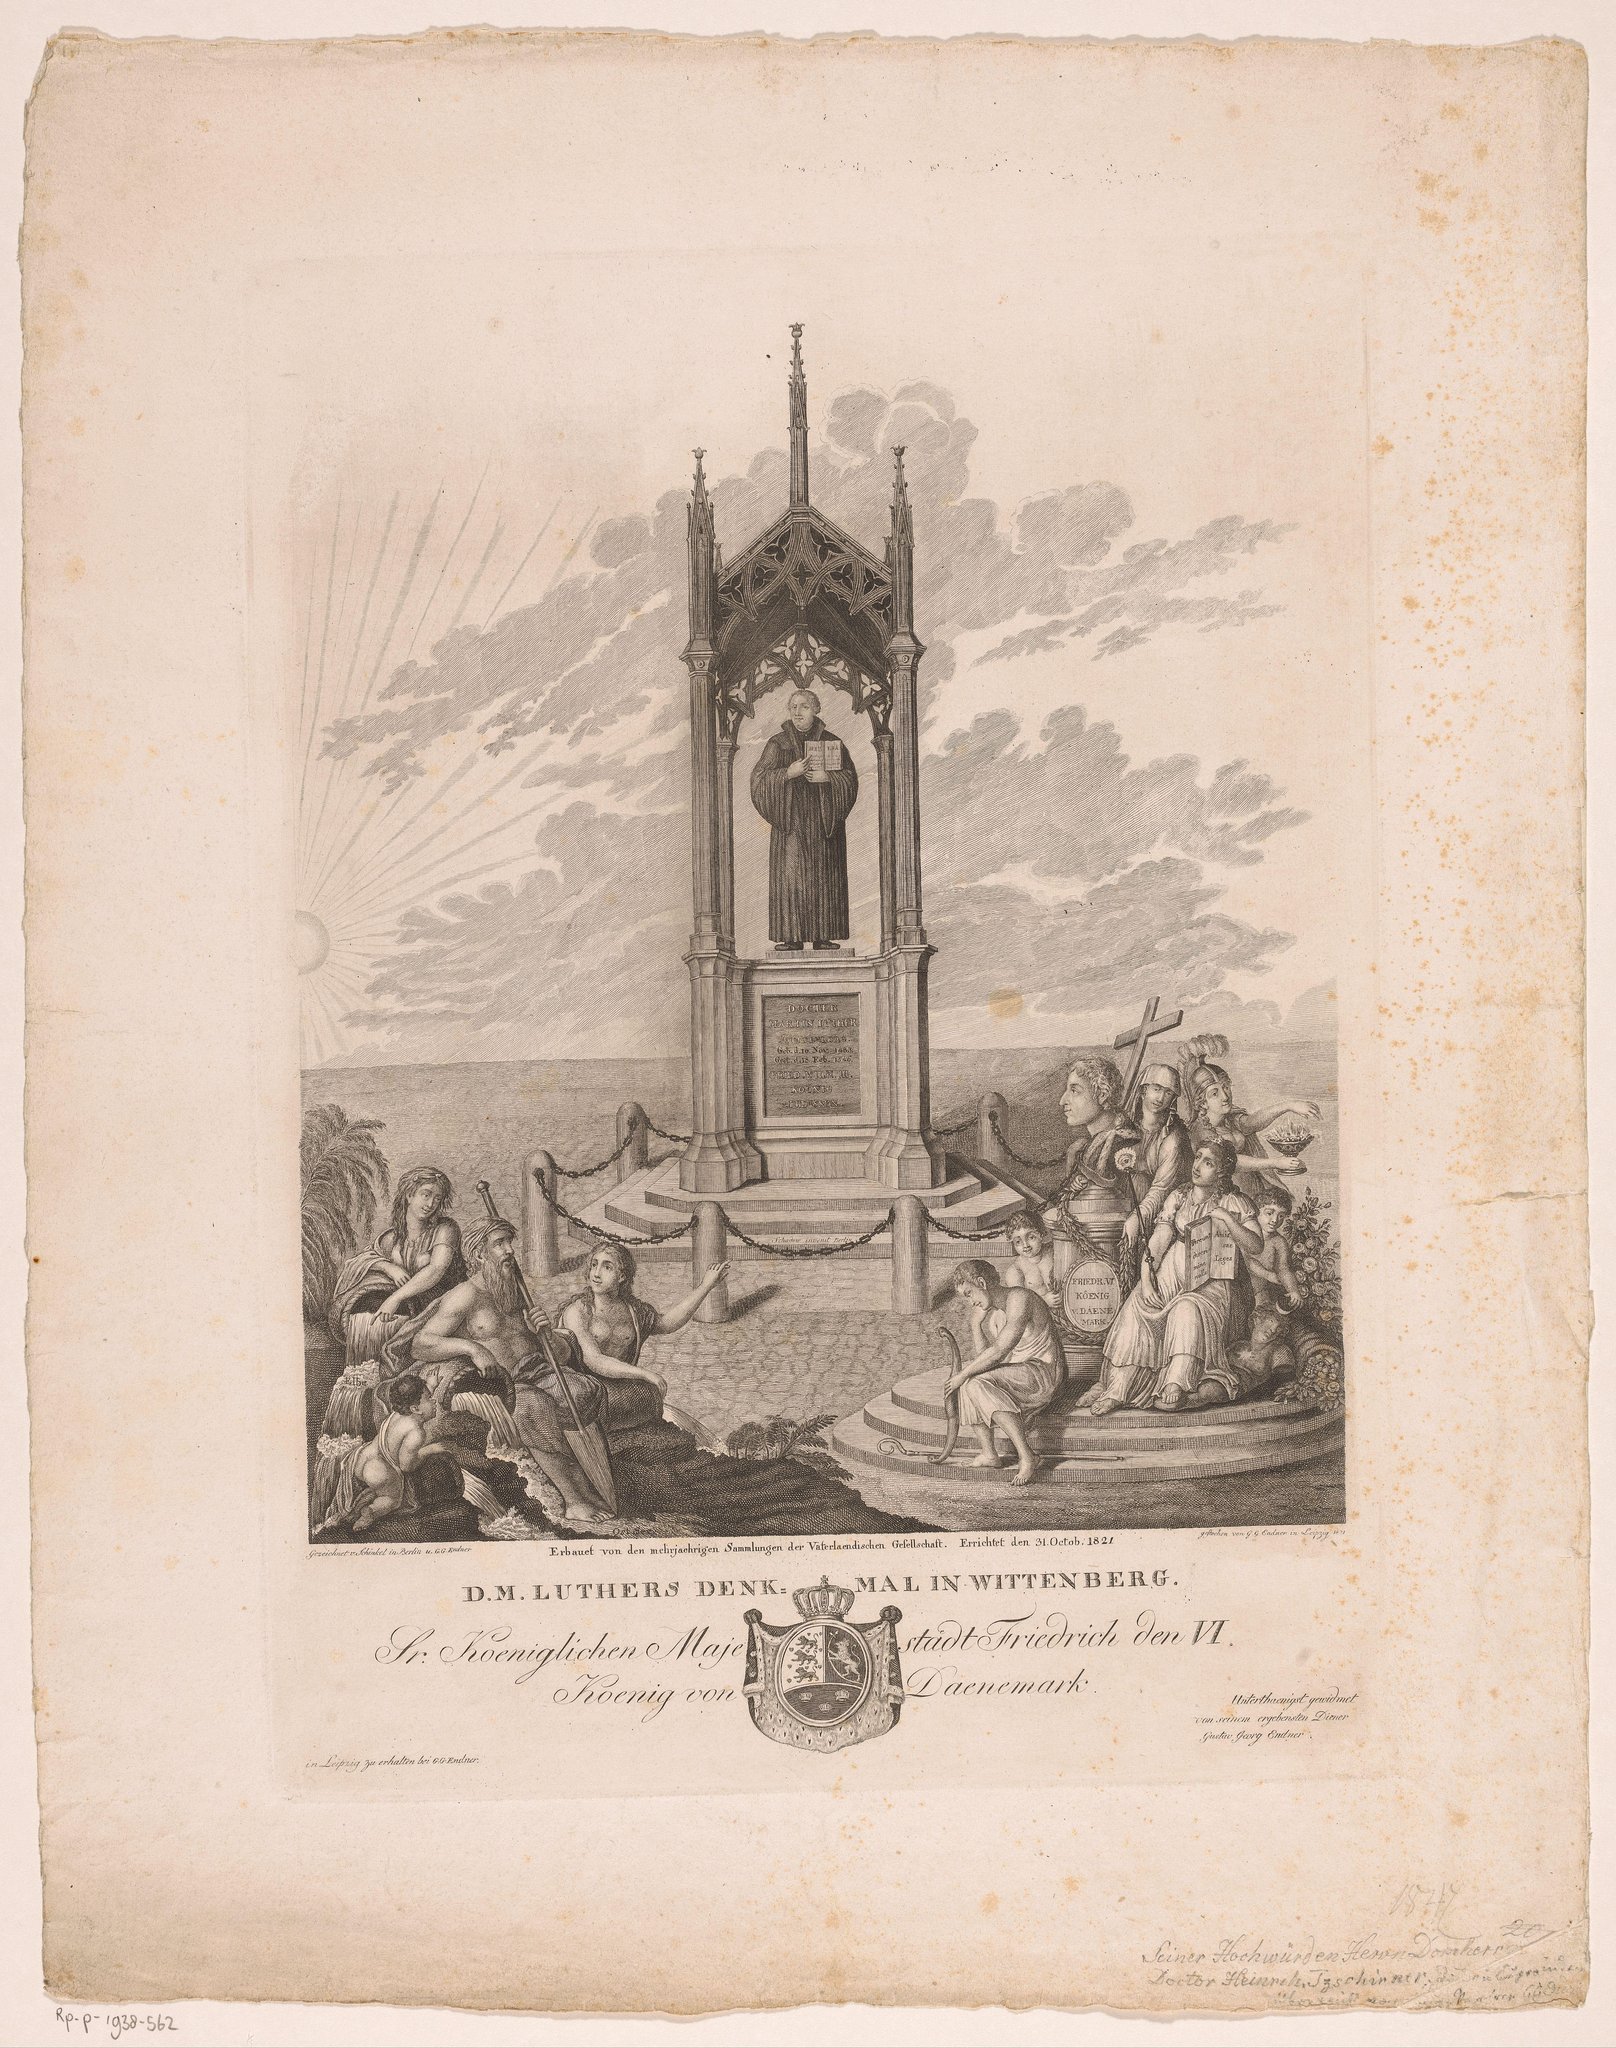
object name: print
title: Monument van Martin Luther in Wittenberg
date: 1821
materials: paper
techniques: etching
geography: berlin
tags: priest, martin luther, fides (faith) as roman personification, 'cornucopia', horn of plenty, chest, bust, river personified, 'fiumi' (ripa), historical persons, monument, statue, armorial bearing, heraldry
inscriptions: collector's mark: Lugt 2228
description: Monument van Martin Luther omgeven door verscheidene personificaties en het borstbeeld van de Deense koning Friedrich VI.